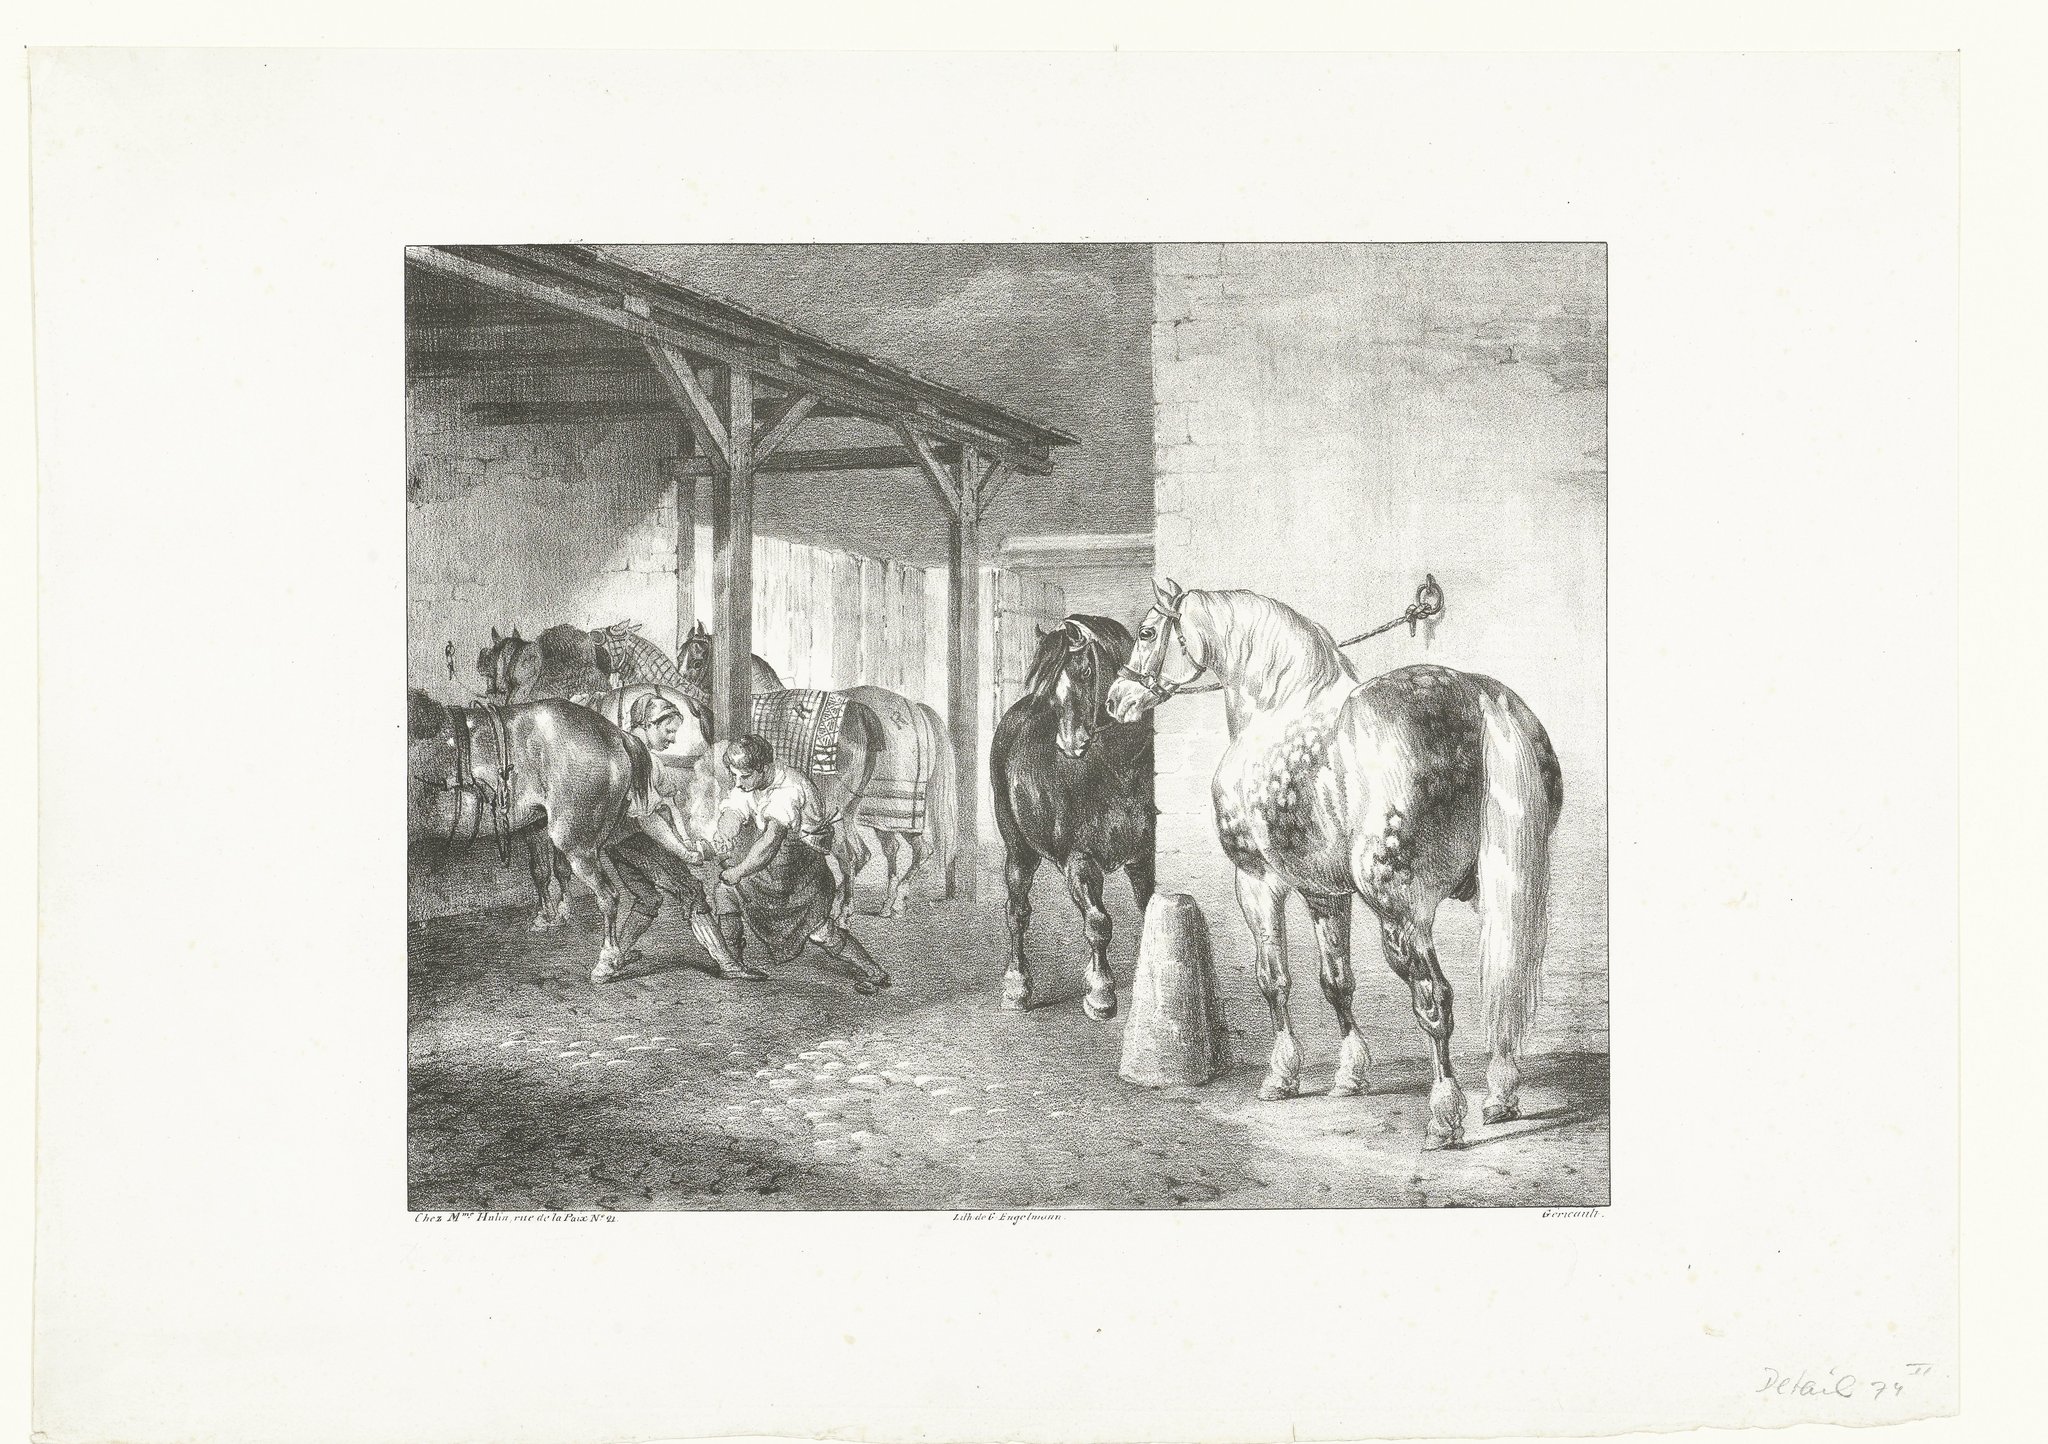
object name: print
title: Quatre Sujets Divers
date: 1823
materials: paper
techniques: lithograph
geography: paris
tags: farrier, shoeing-smith, horse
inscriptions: collector's mark: Lugt 2228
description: De schuur van een hoefsmid met een aantal paarden. Een man houdt de achterhoef van een paard vast, de smid duwt het hete ijzer er tegenaan.